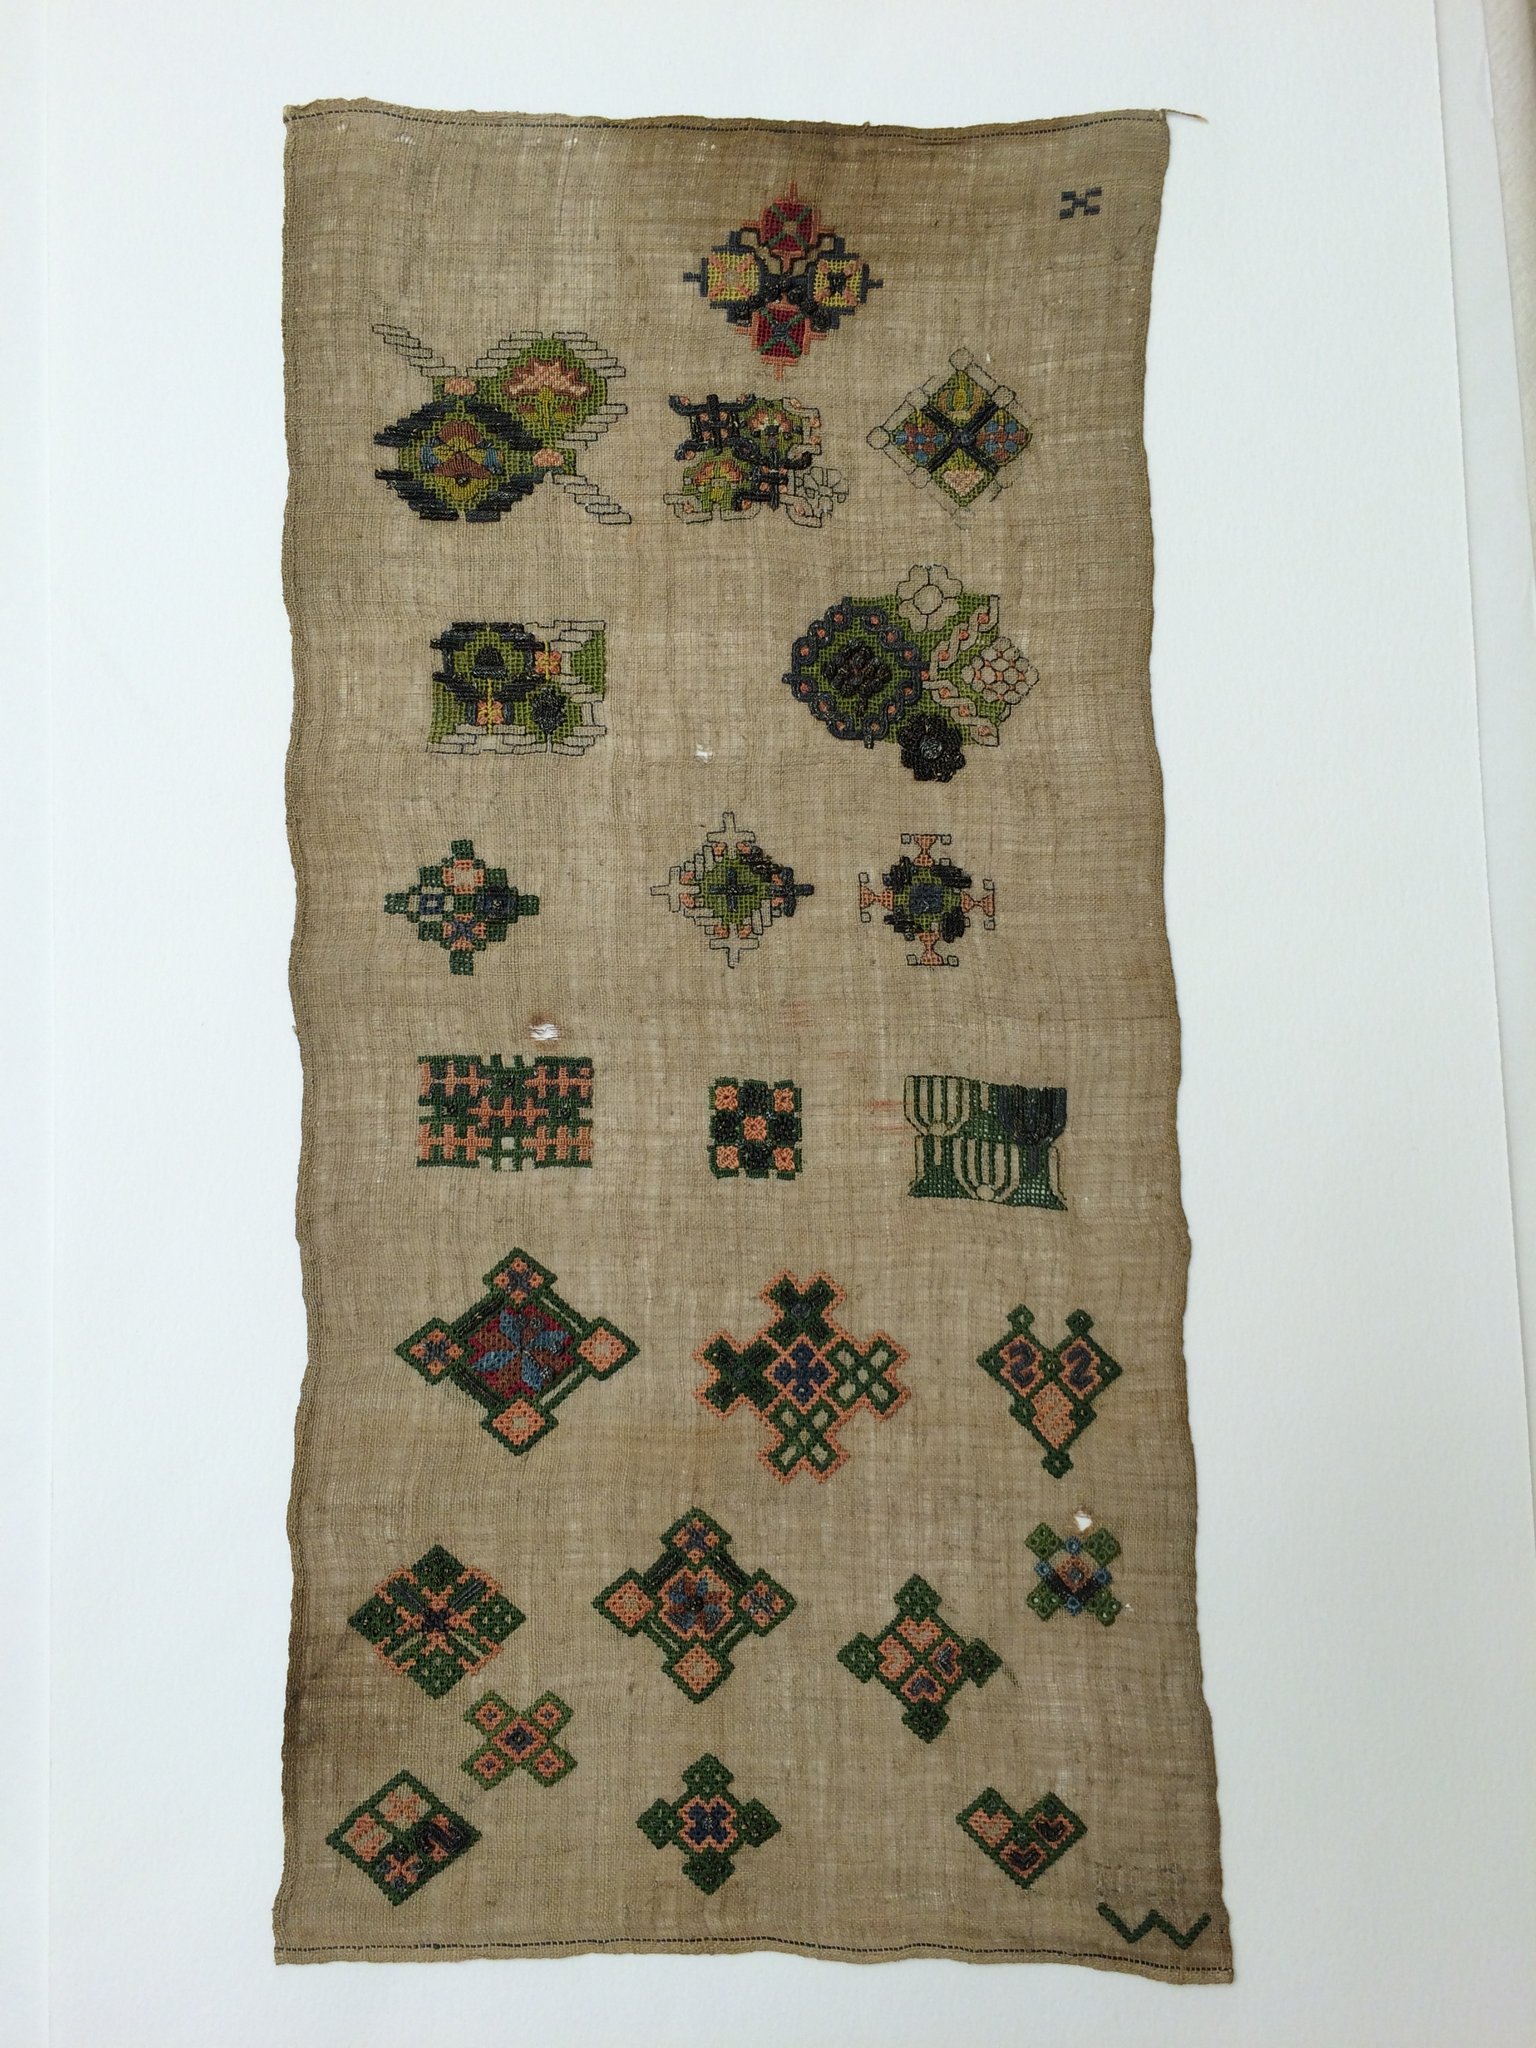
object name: sampler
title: Embroidered spot sampler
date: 1601-1650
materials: linen, metal thread, silk